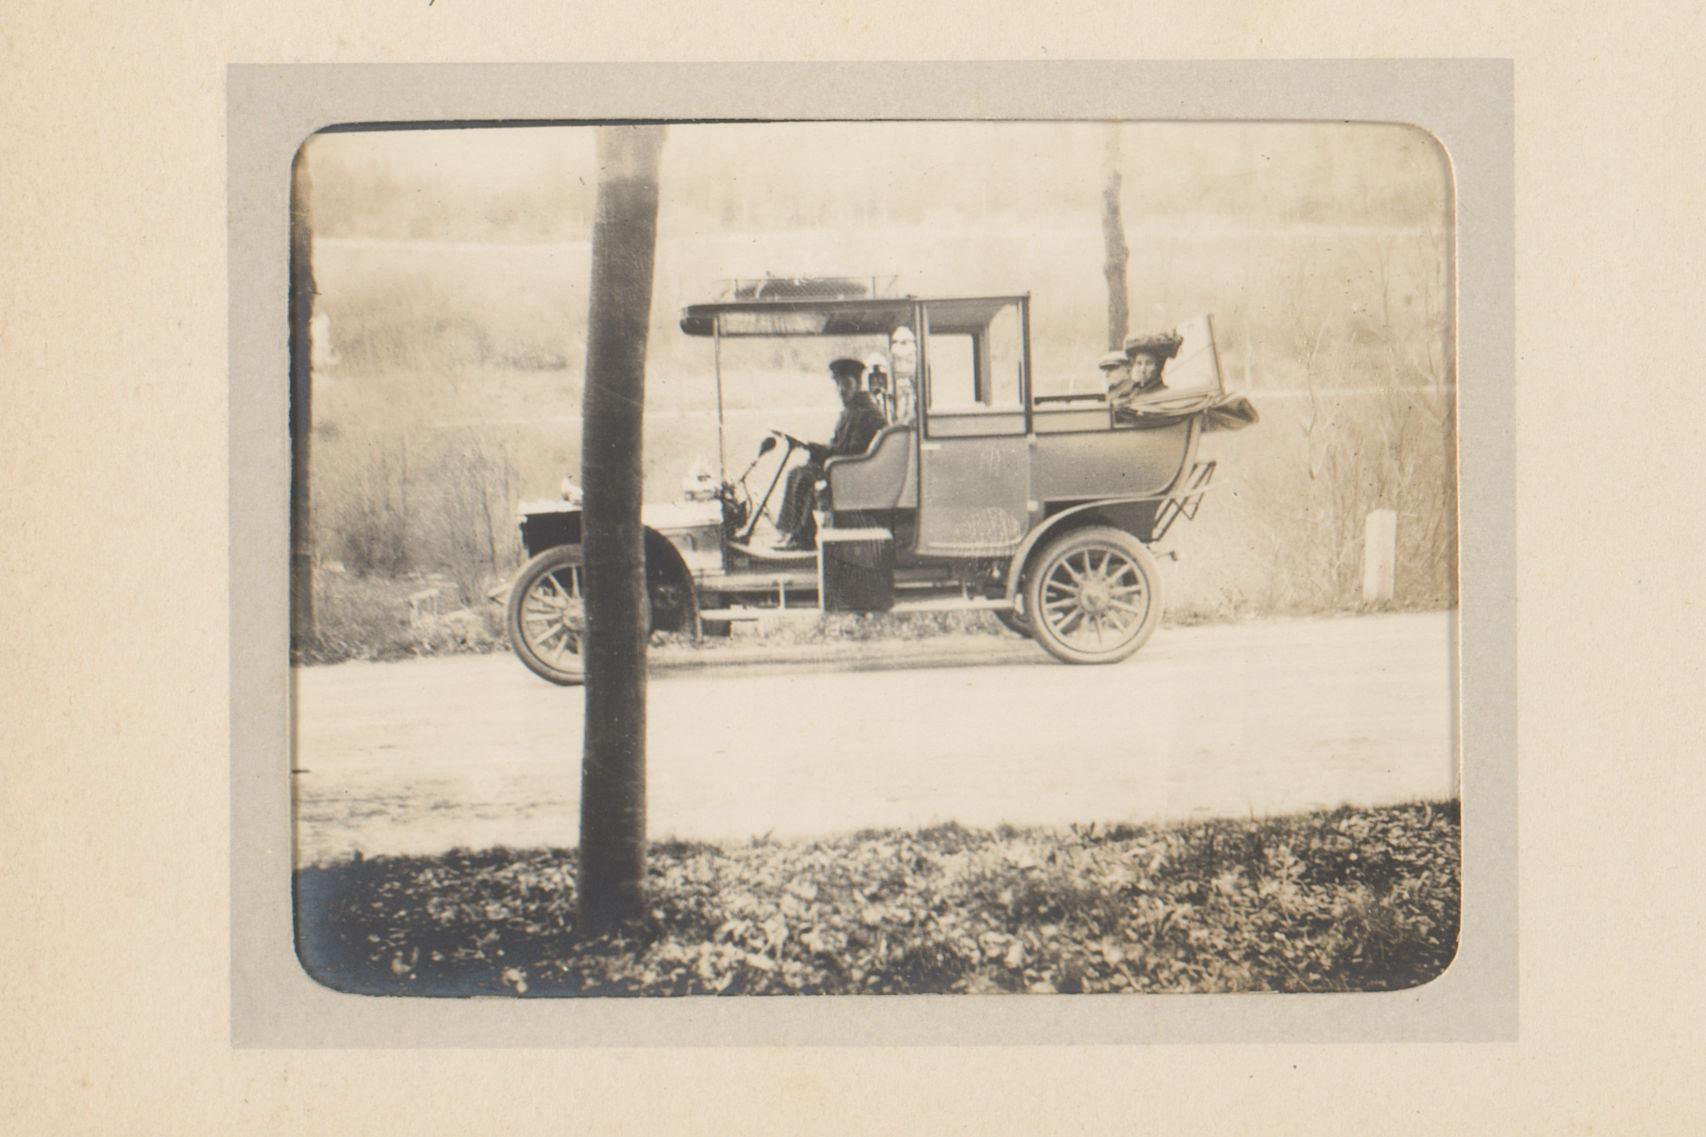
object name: photograph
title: Auto met chauffeur met achterin een man en vrouw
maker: liesbeth overhoff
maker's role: fotograaf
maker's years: 1895-1969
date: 1911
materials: paper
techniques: gelatin silver print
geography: wiesbaden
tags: adult woman, adult man, automobile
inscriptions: inscription: ‘Wiesbaden 1911’